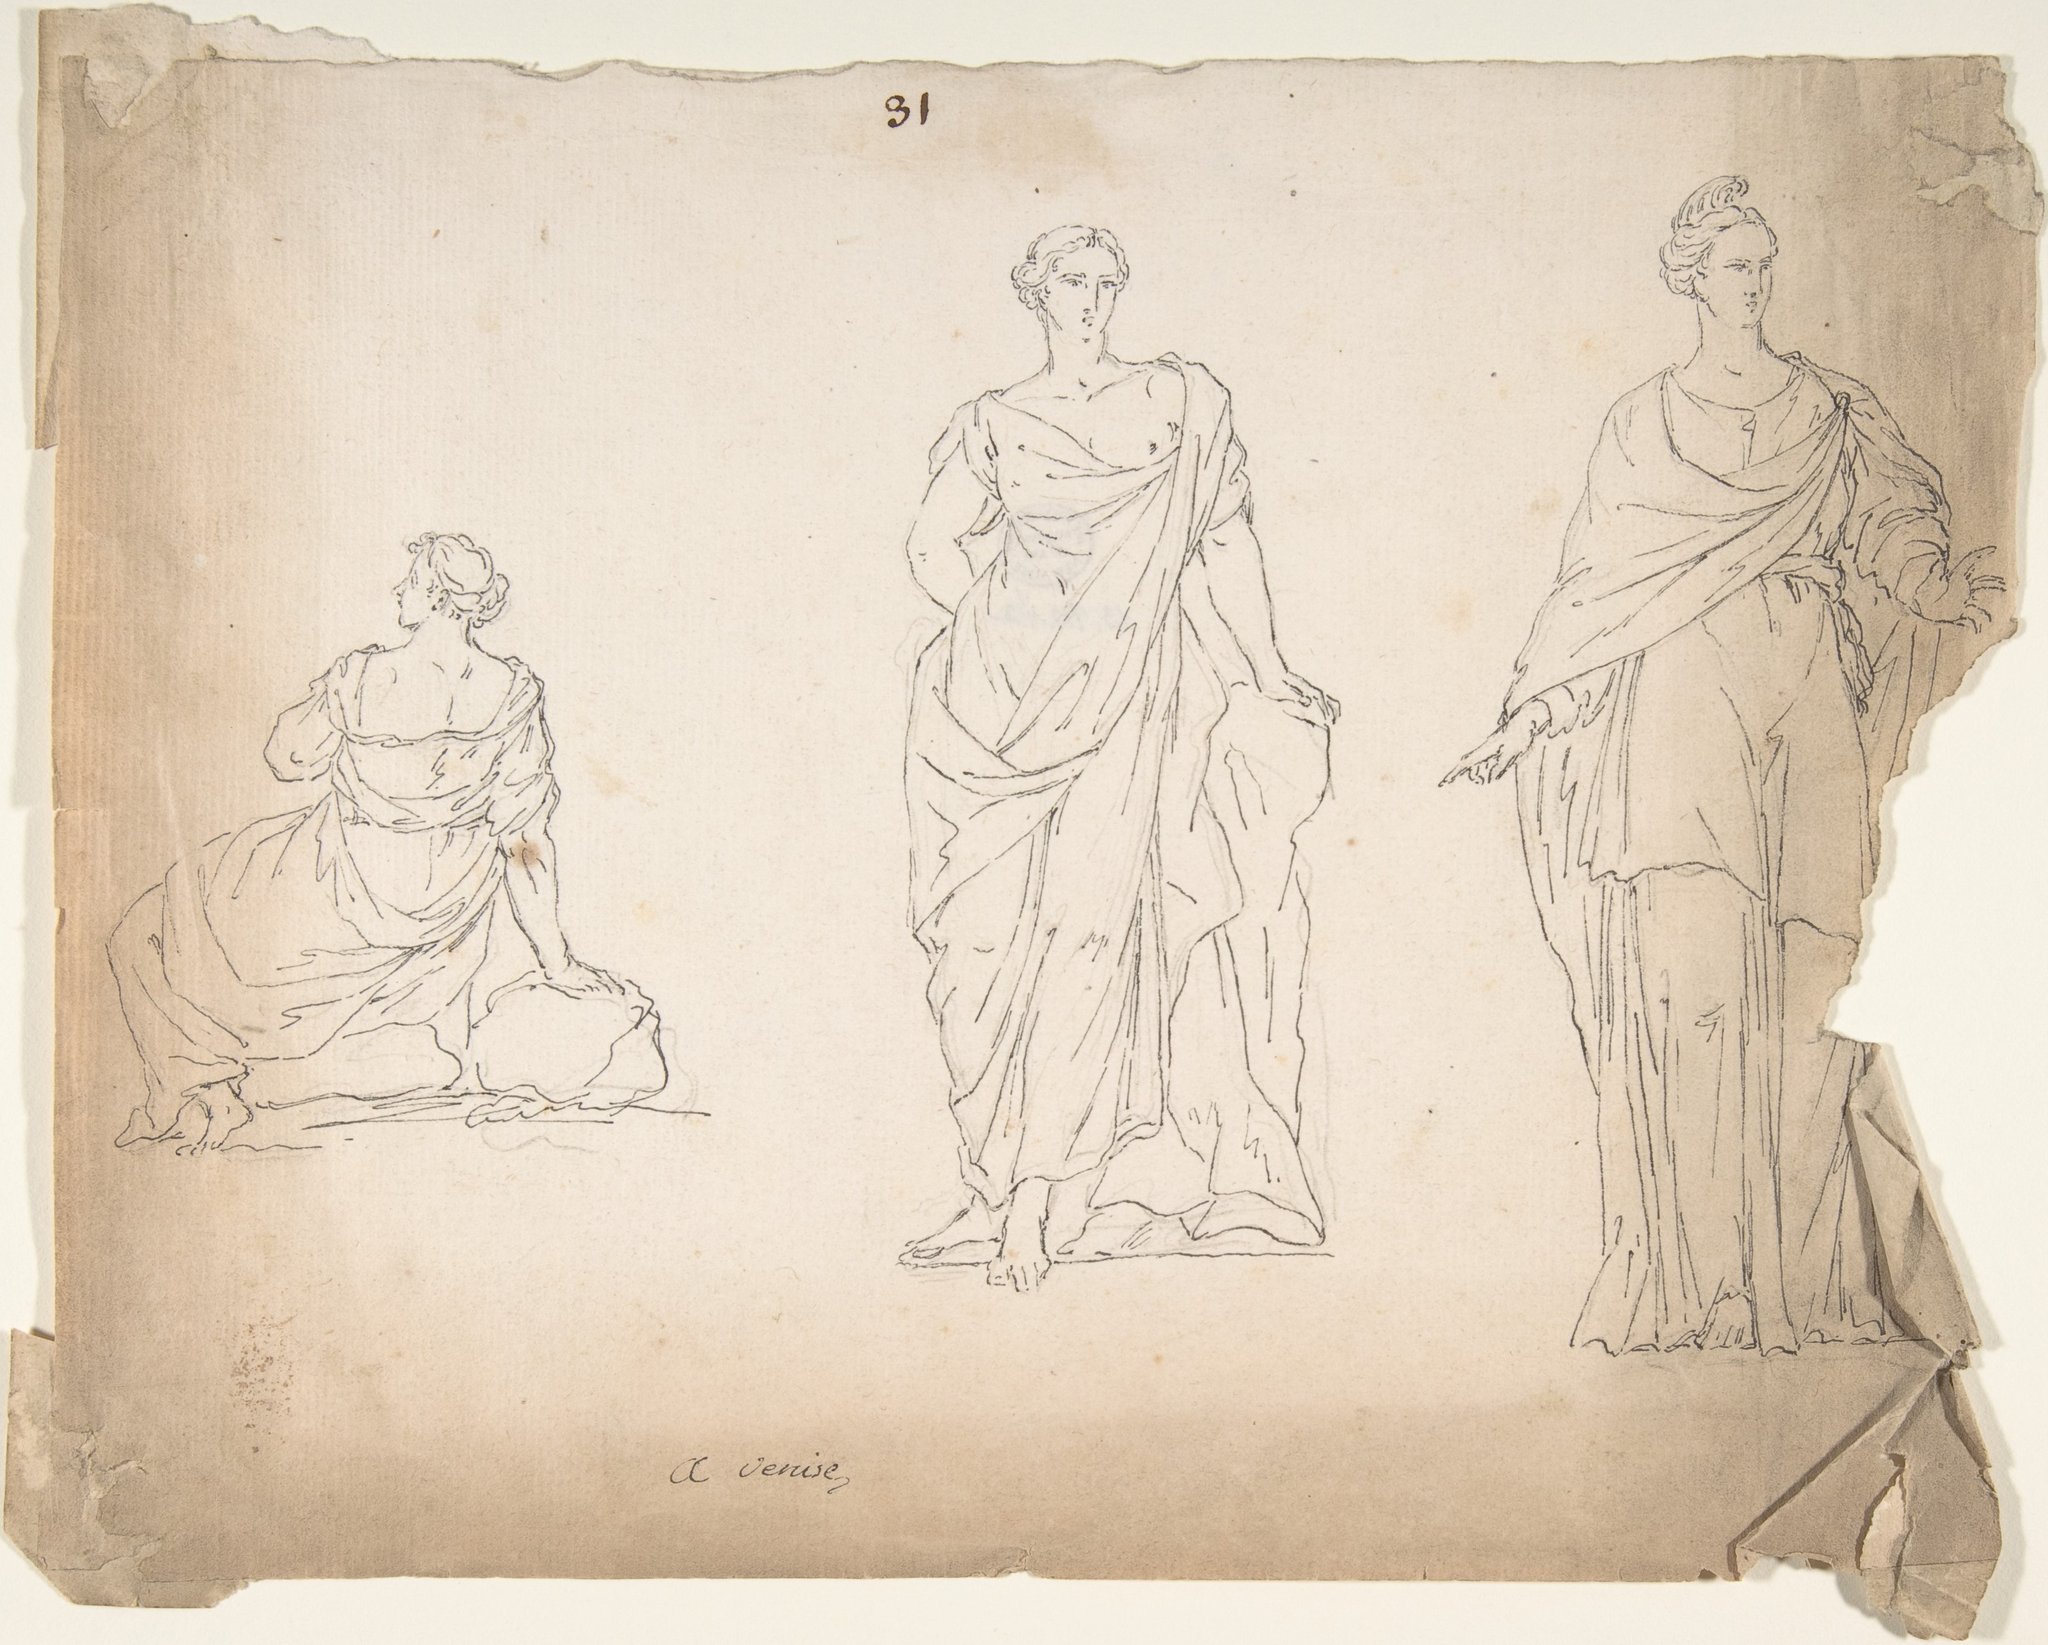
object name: drawing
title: Studies of Female Statues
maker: anonymous, french, 18th century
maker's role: artist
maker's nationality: french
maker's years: 1700-1800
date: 1701-1800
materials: graphite, ink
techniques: pen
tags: women